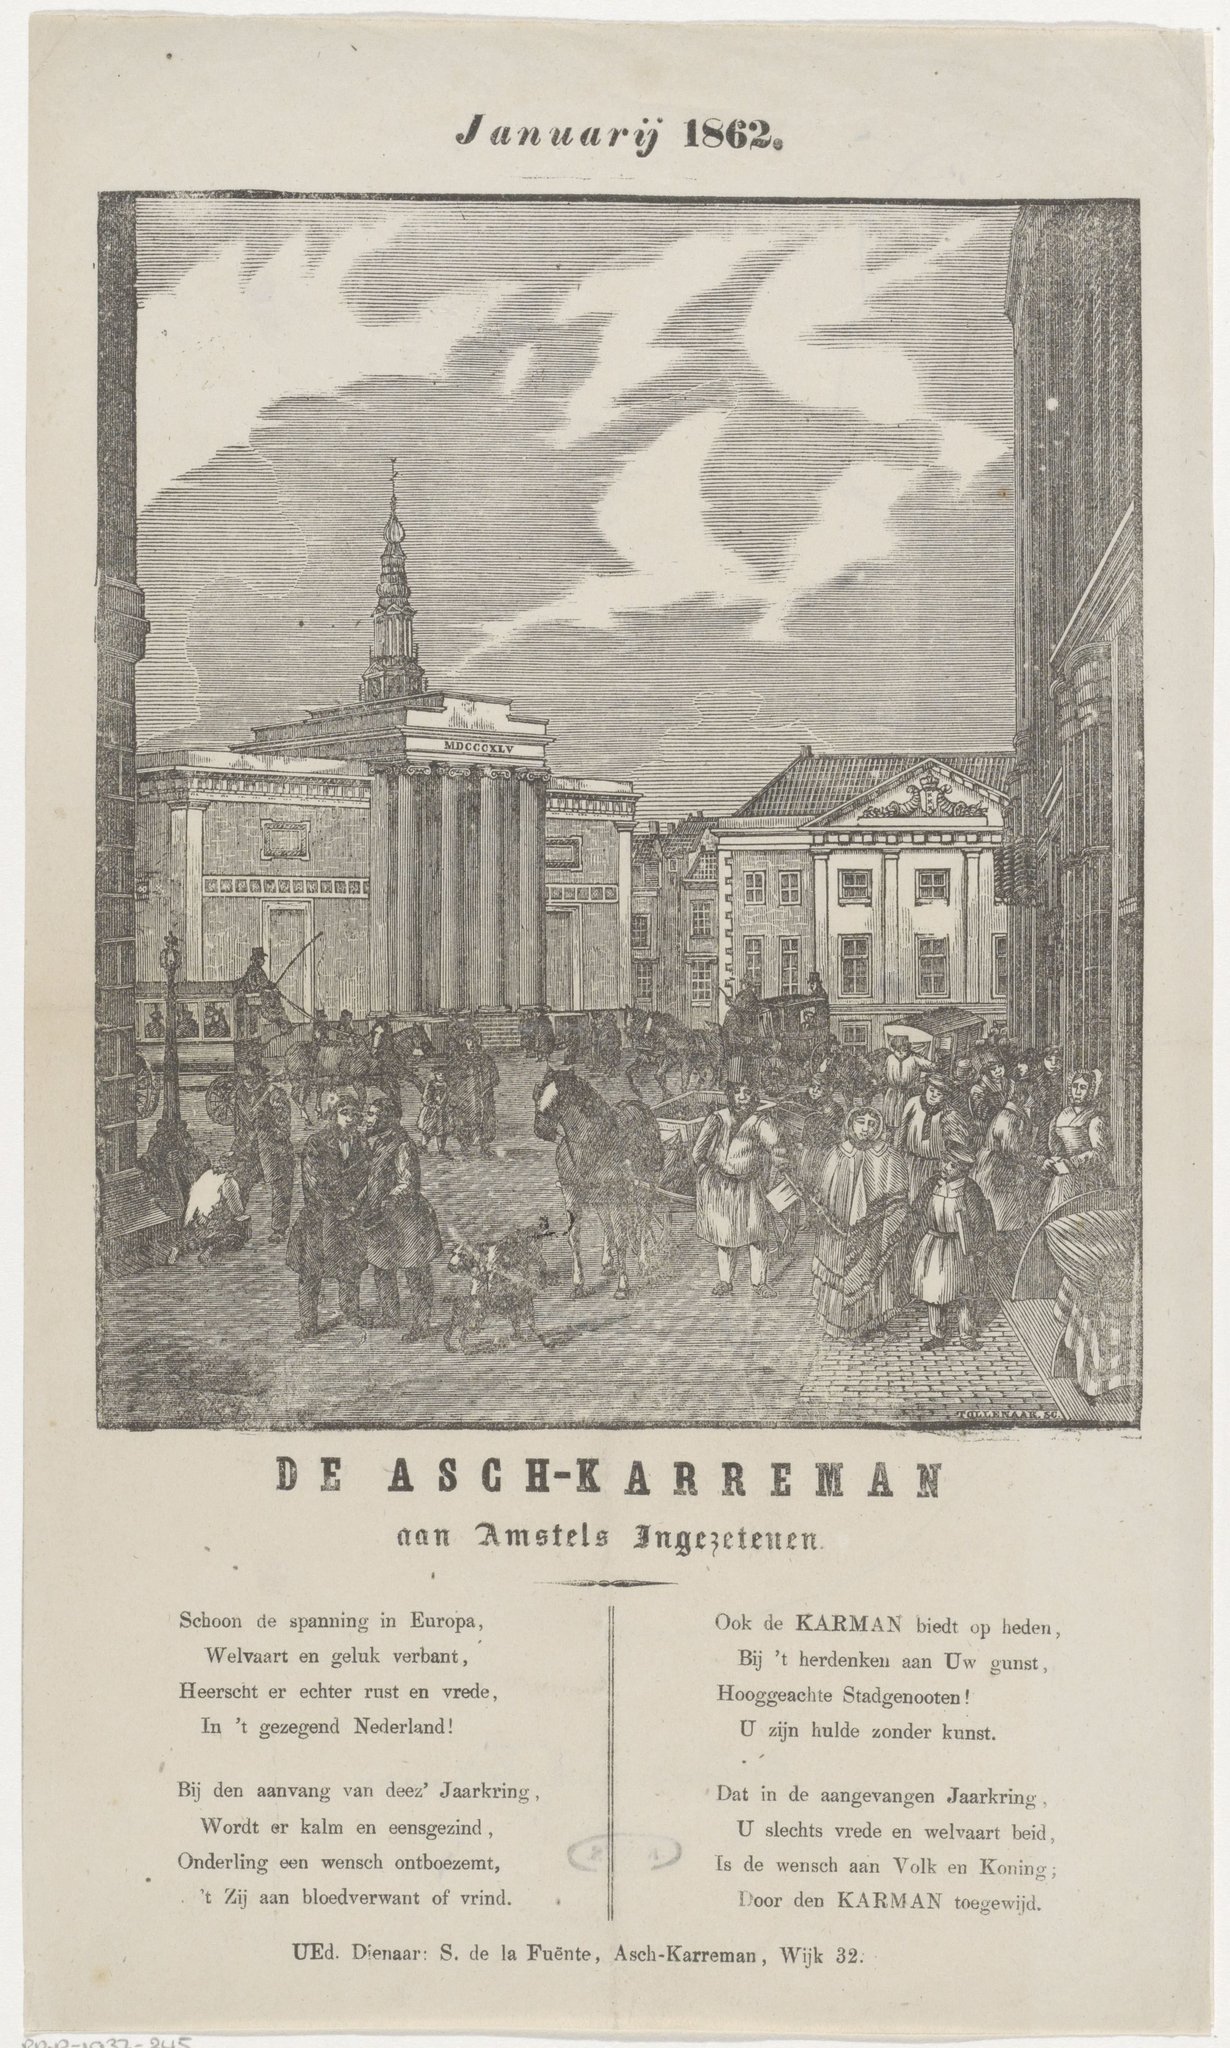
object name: print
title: Nieuwjaarswens van de Amsterdamse askarrenmannen voor het jaar 1862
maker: antonie vink tollenaar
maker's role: print maker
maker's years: 1805-1875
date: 1862-1864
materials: paper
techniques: letterpress printing, engraving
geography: netherlands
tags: square, place, circus, etc., garbage collection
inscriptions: collector's mark: Lugt 2228, collector's mark: Lugt 2760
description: Gezicht op de Dam te Amsterdam met de Beurs van Zocher en het Commandantshuis. Tussen het publiek de vuilnismannen met hun kar. Daaronder twee kolommen met elk acht regels Nederlandse tekst. Namens S. de la Fuënte, de askarreman van wijk no. 32.